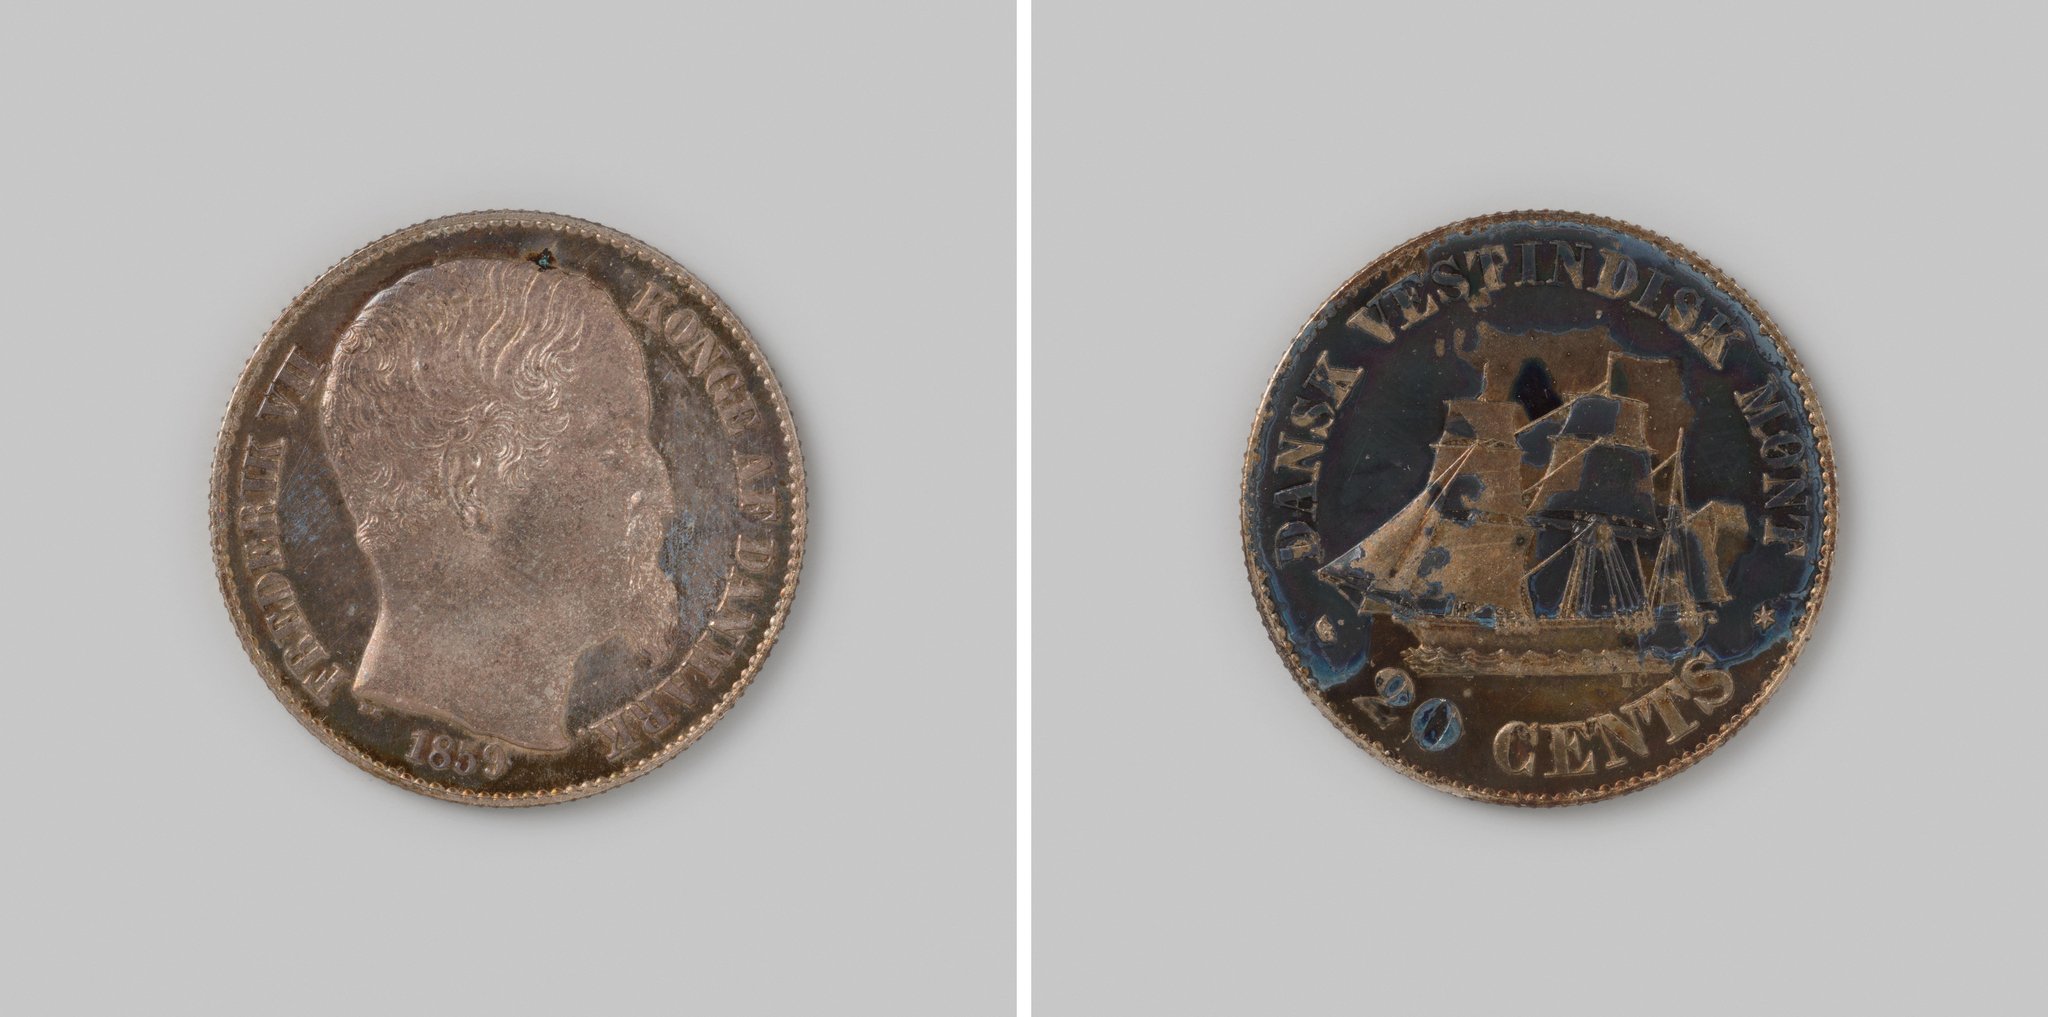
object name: coin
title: Deens West-Indië, koning Frederik VII, 20 cents,1859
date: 1859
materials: silver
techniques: striking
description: Zilveren munt. Voorzijde: hoofd van de koning naar rechts. Daaronder jaartal. Keerzijde: driemaster varend naar links. Waarde-aanduiding onderaan in omschrift. Kartelrand.